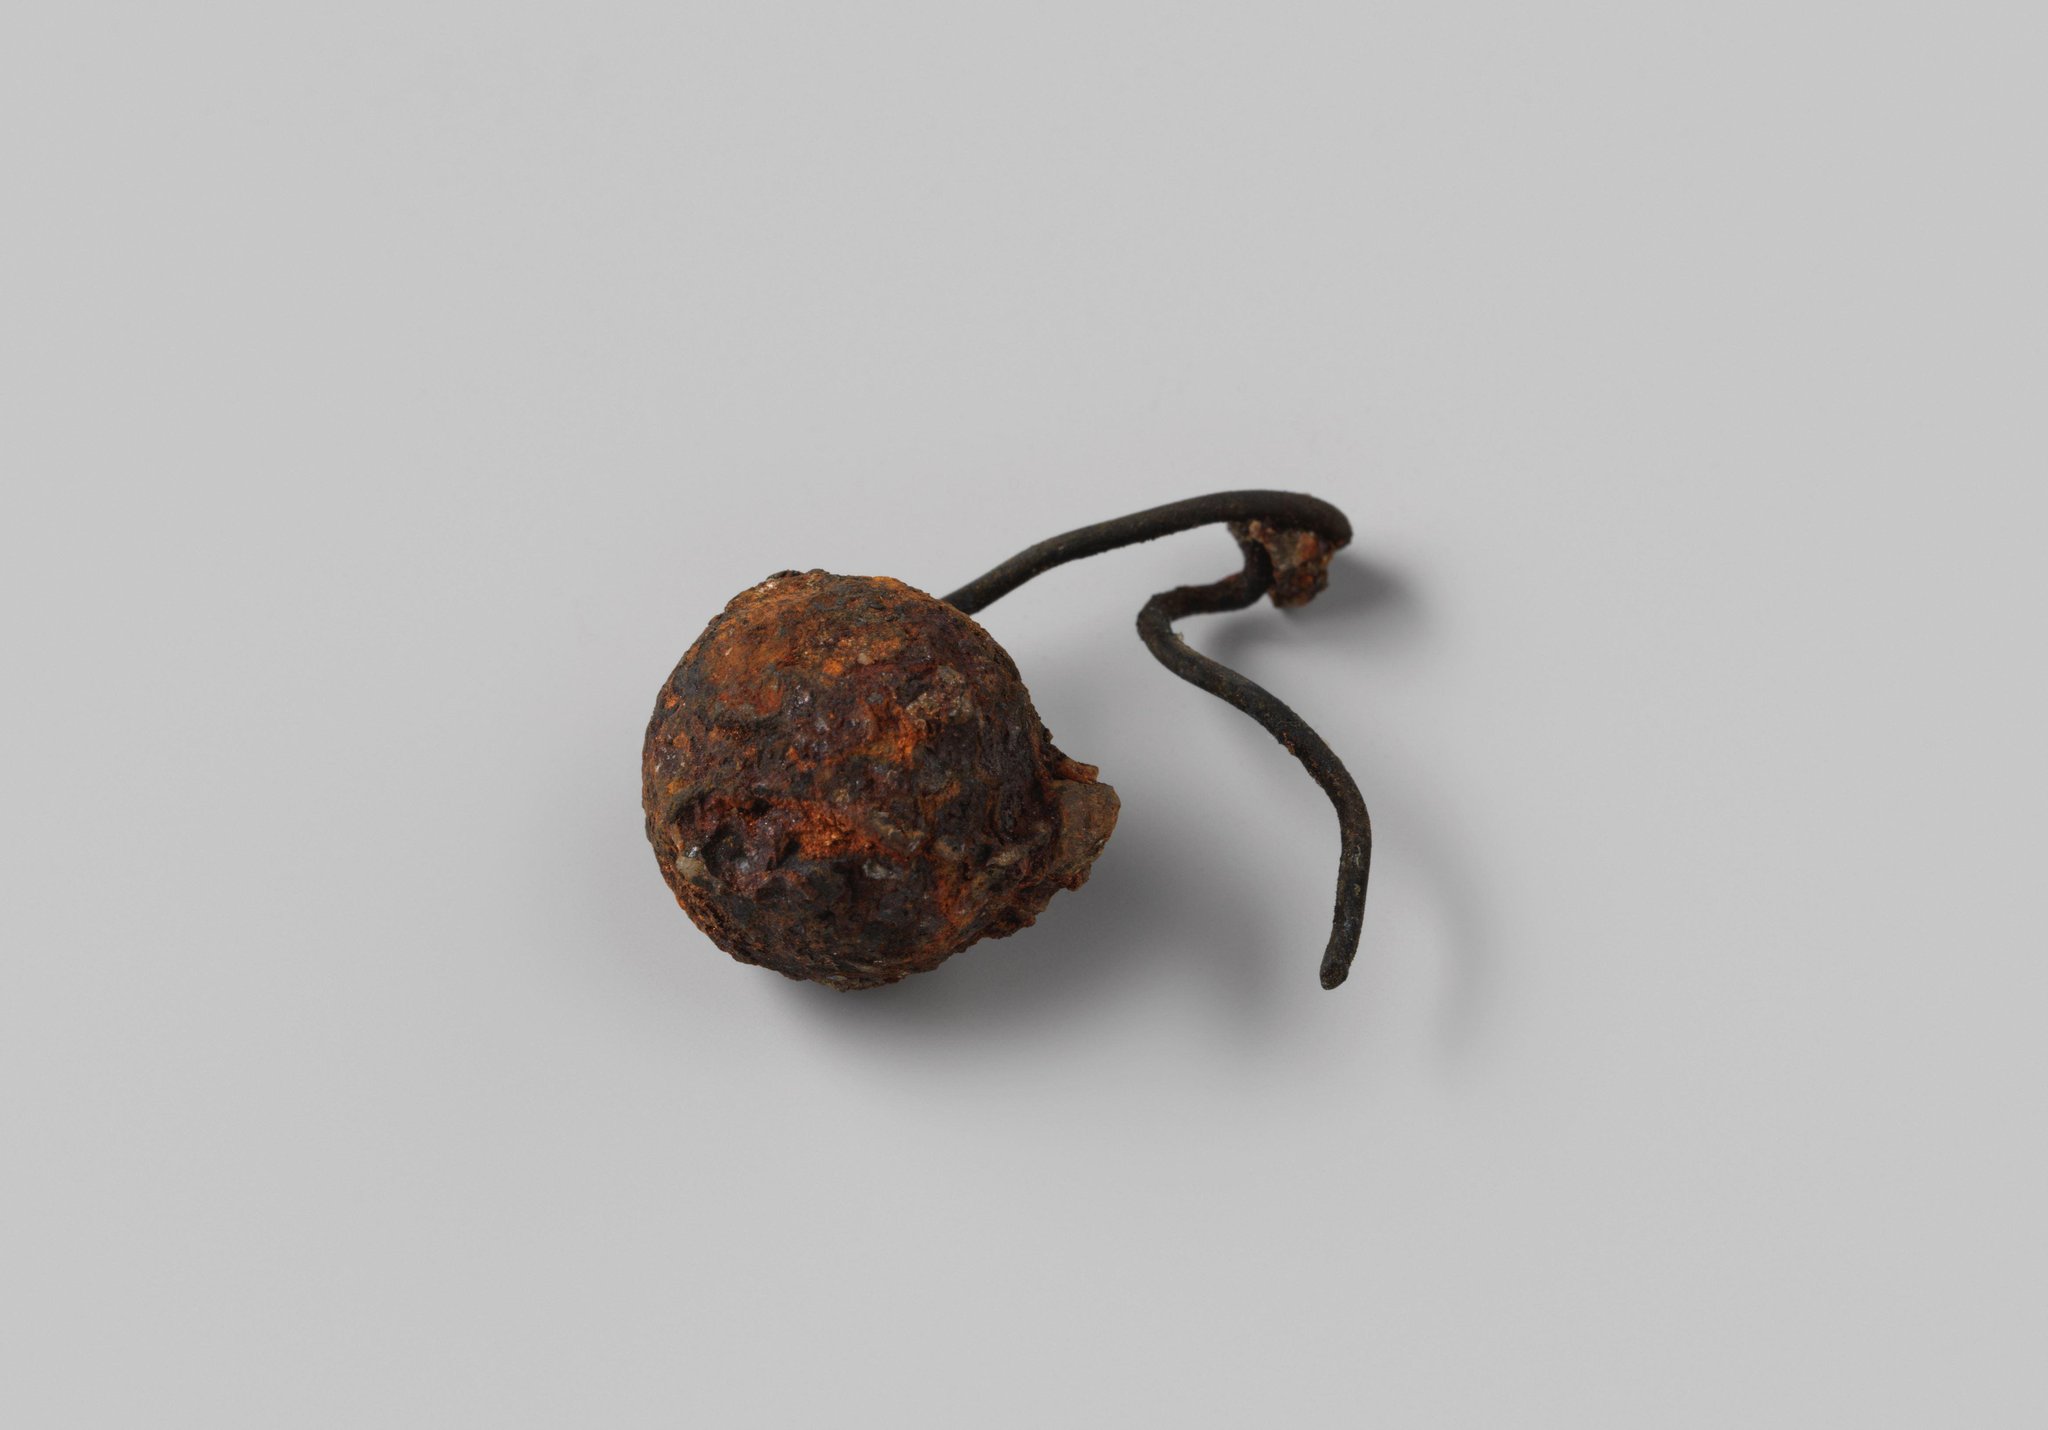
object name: chain shot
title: Kettingkogel uit het wrak van de Oost-Indiëvaarder Hollandia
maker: Anonymous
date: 1700-1743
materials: lead, metal thread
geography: netherlands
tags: verenigde oostindische compagnie, hollandia (schip), annet